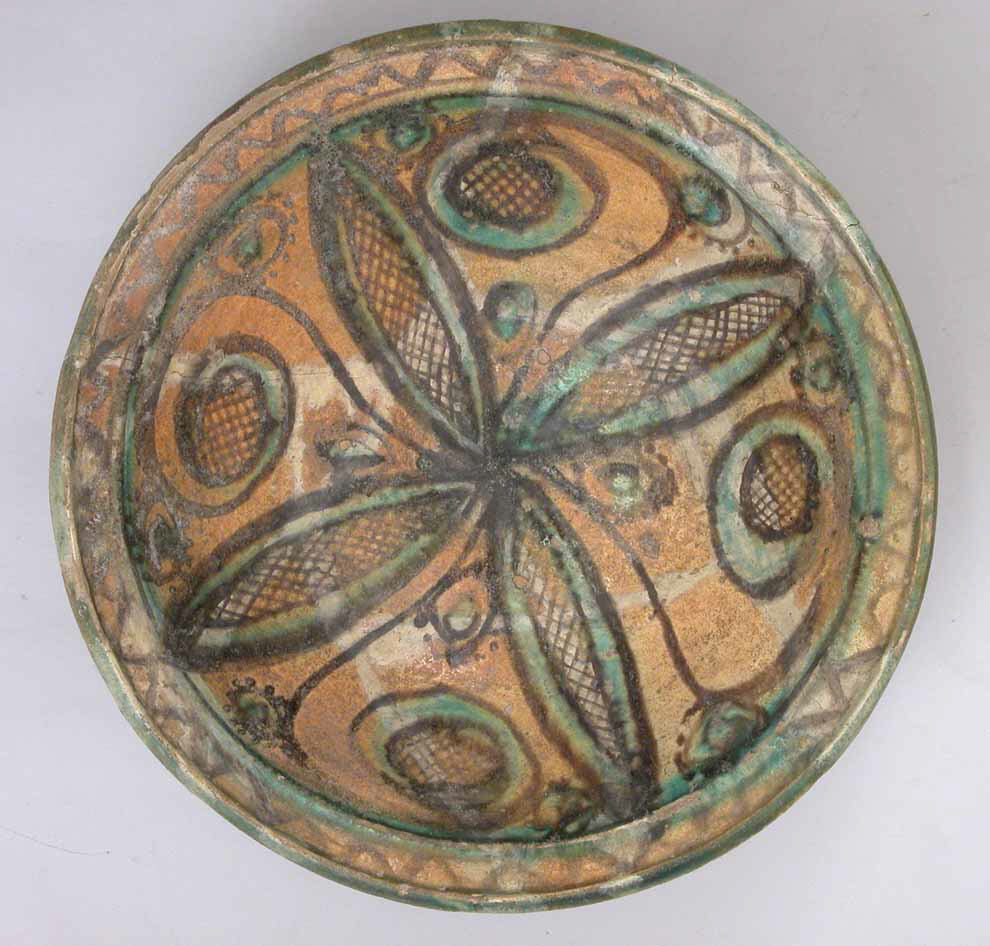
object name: plate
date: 1301-1400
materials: earthenware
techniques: glazing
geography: syria